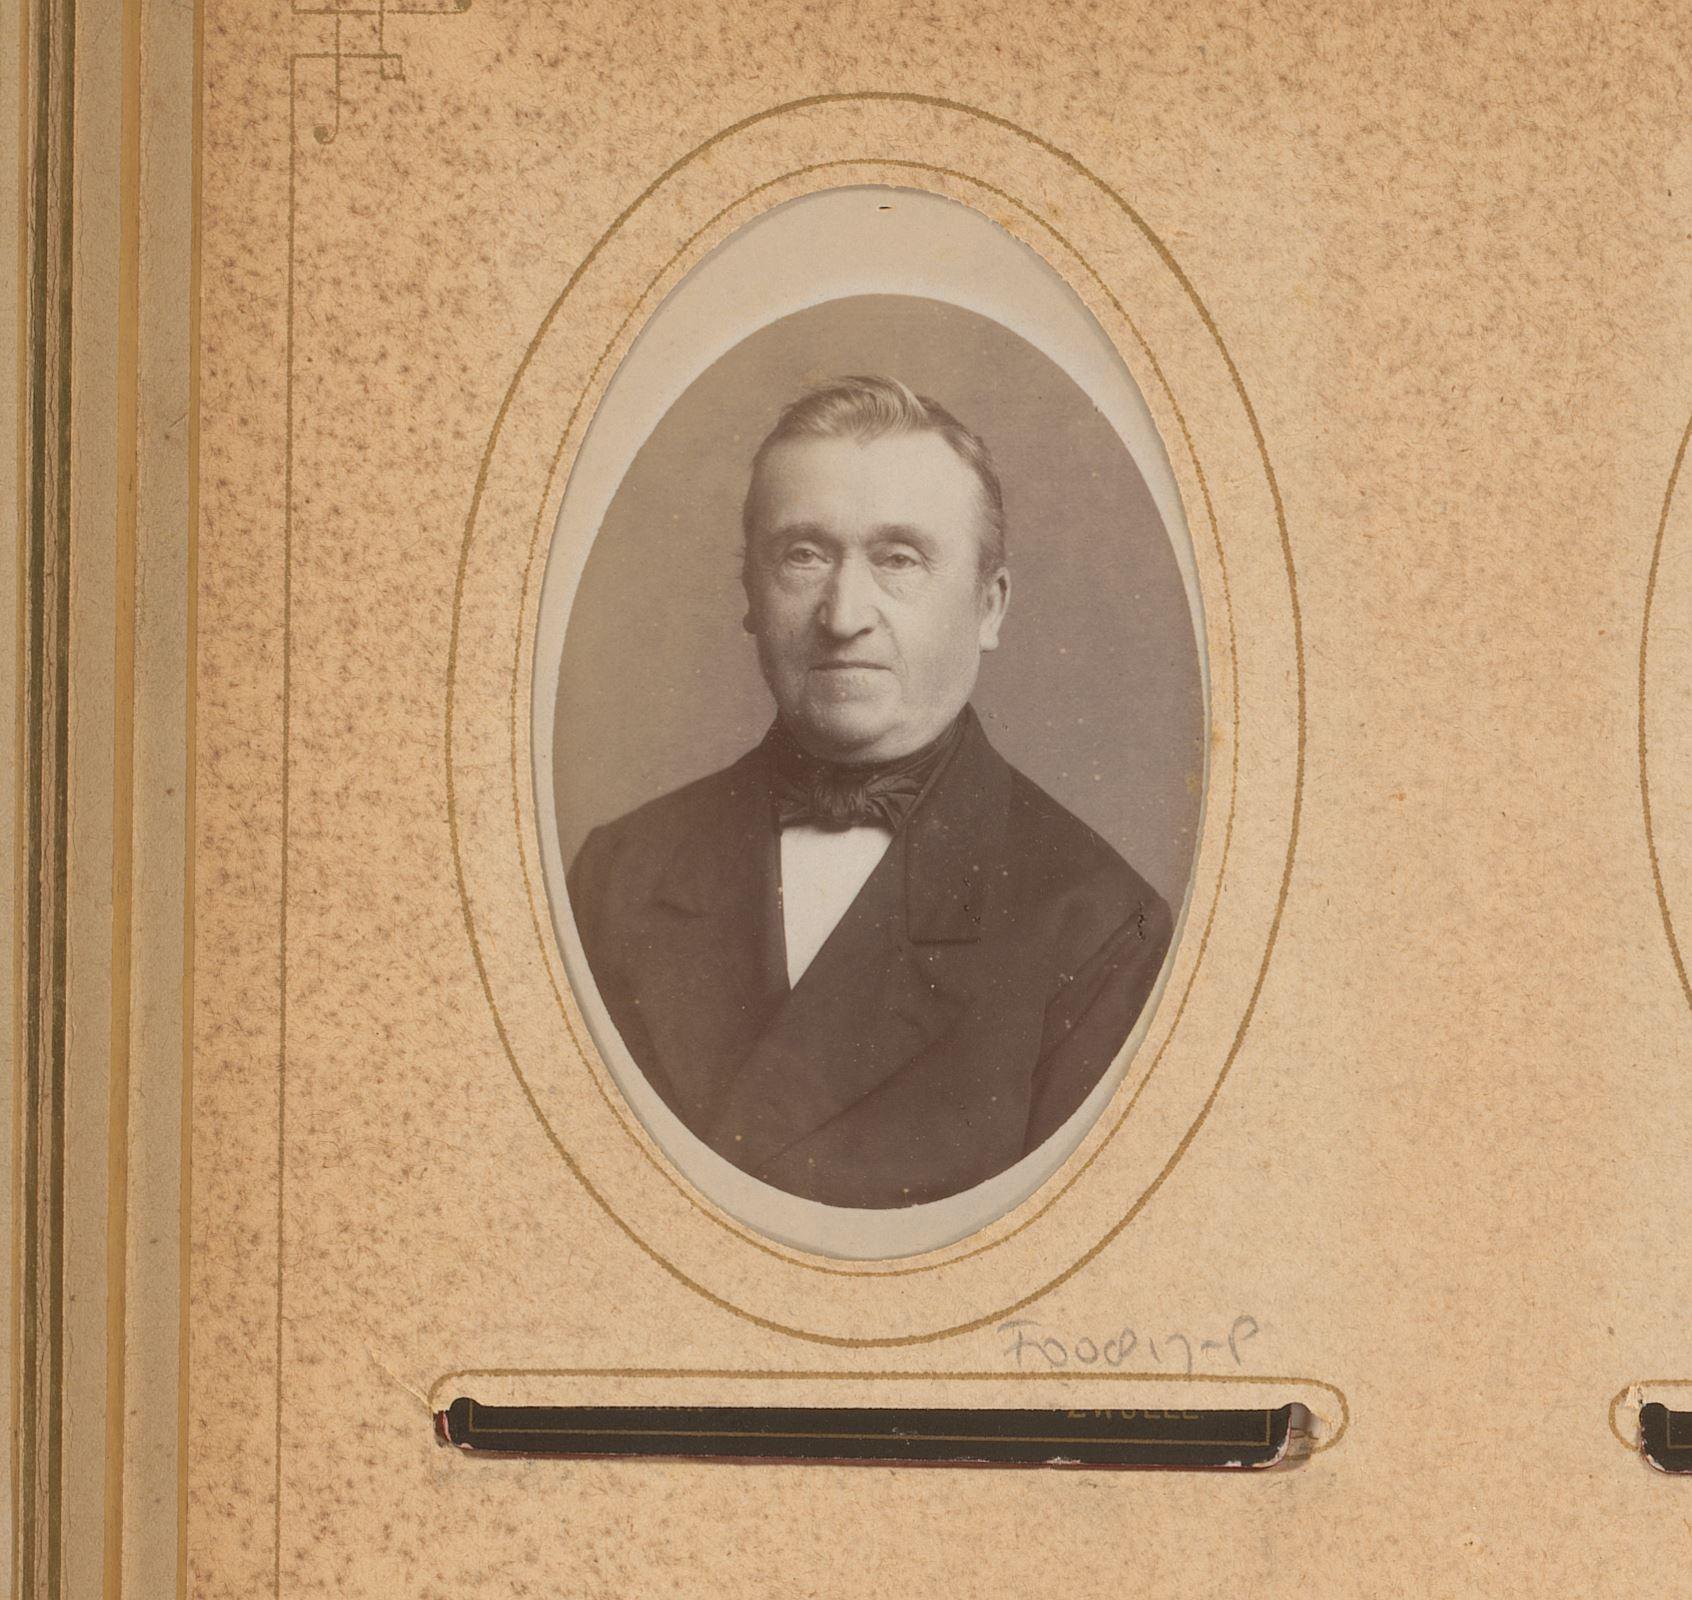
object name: album leaf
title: Portret van een man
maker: franz wilhelm heinrich deutmann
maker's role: fotograaf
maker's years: 1840-1906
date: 1865-1905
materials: cardboard, photographic support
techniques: albumen print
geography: zwolle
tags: historical persons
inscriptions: inscription: ‘F.W.H. Deutmann/ Photograph. Atelier/ Kamperstraat/ Zwolle’